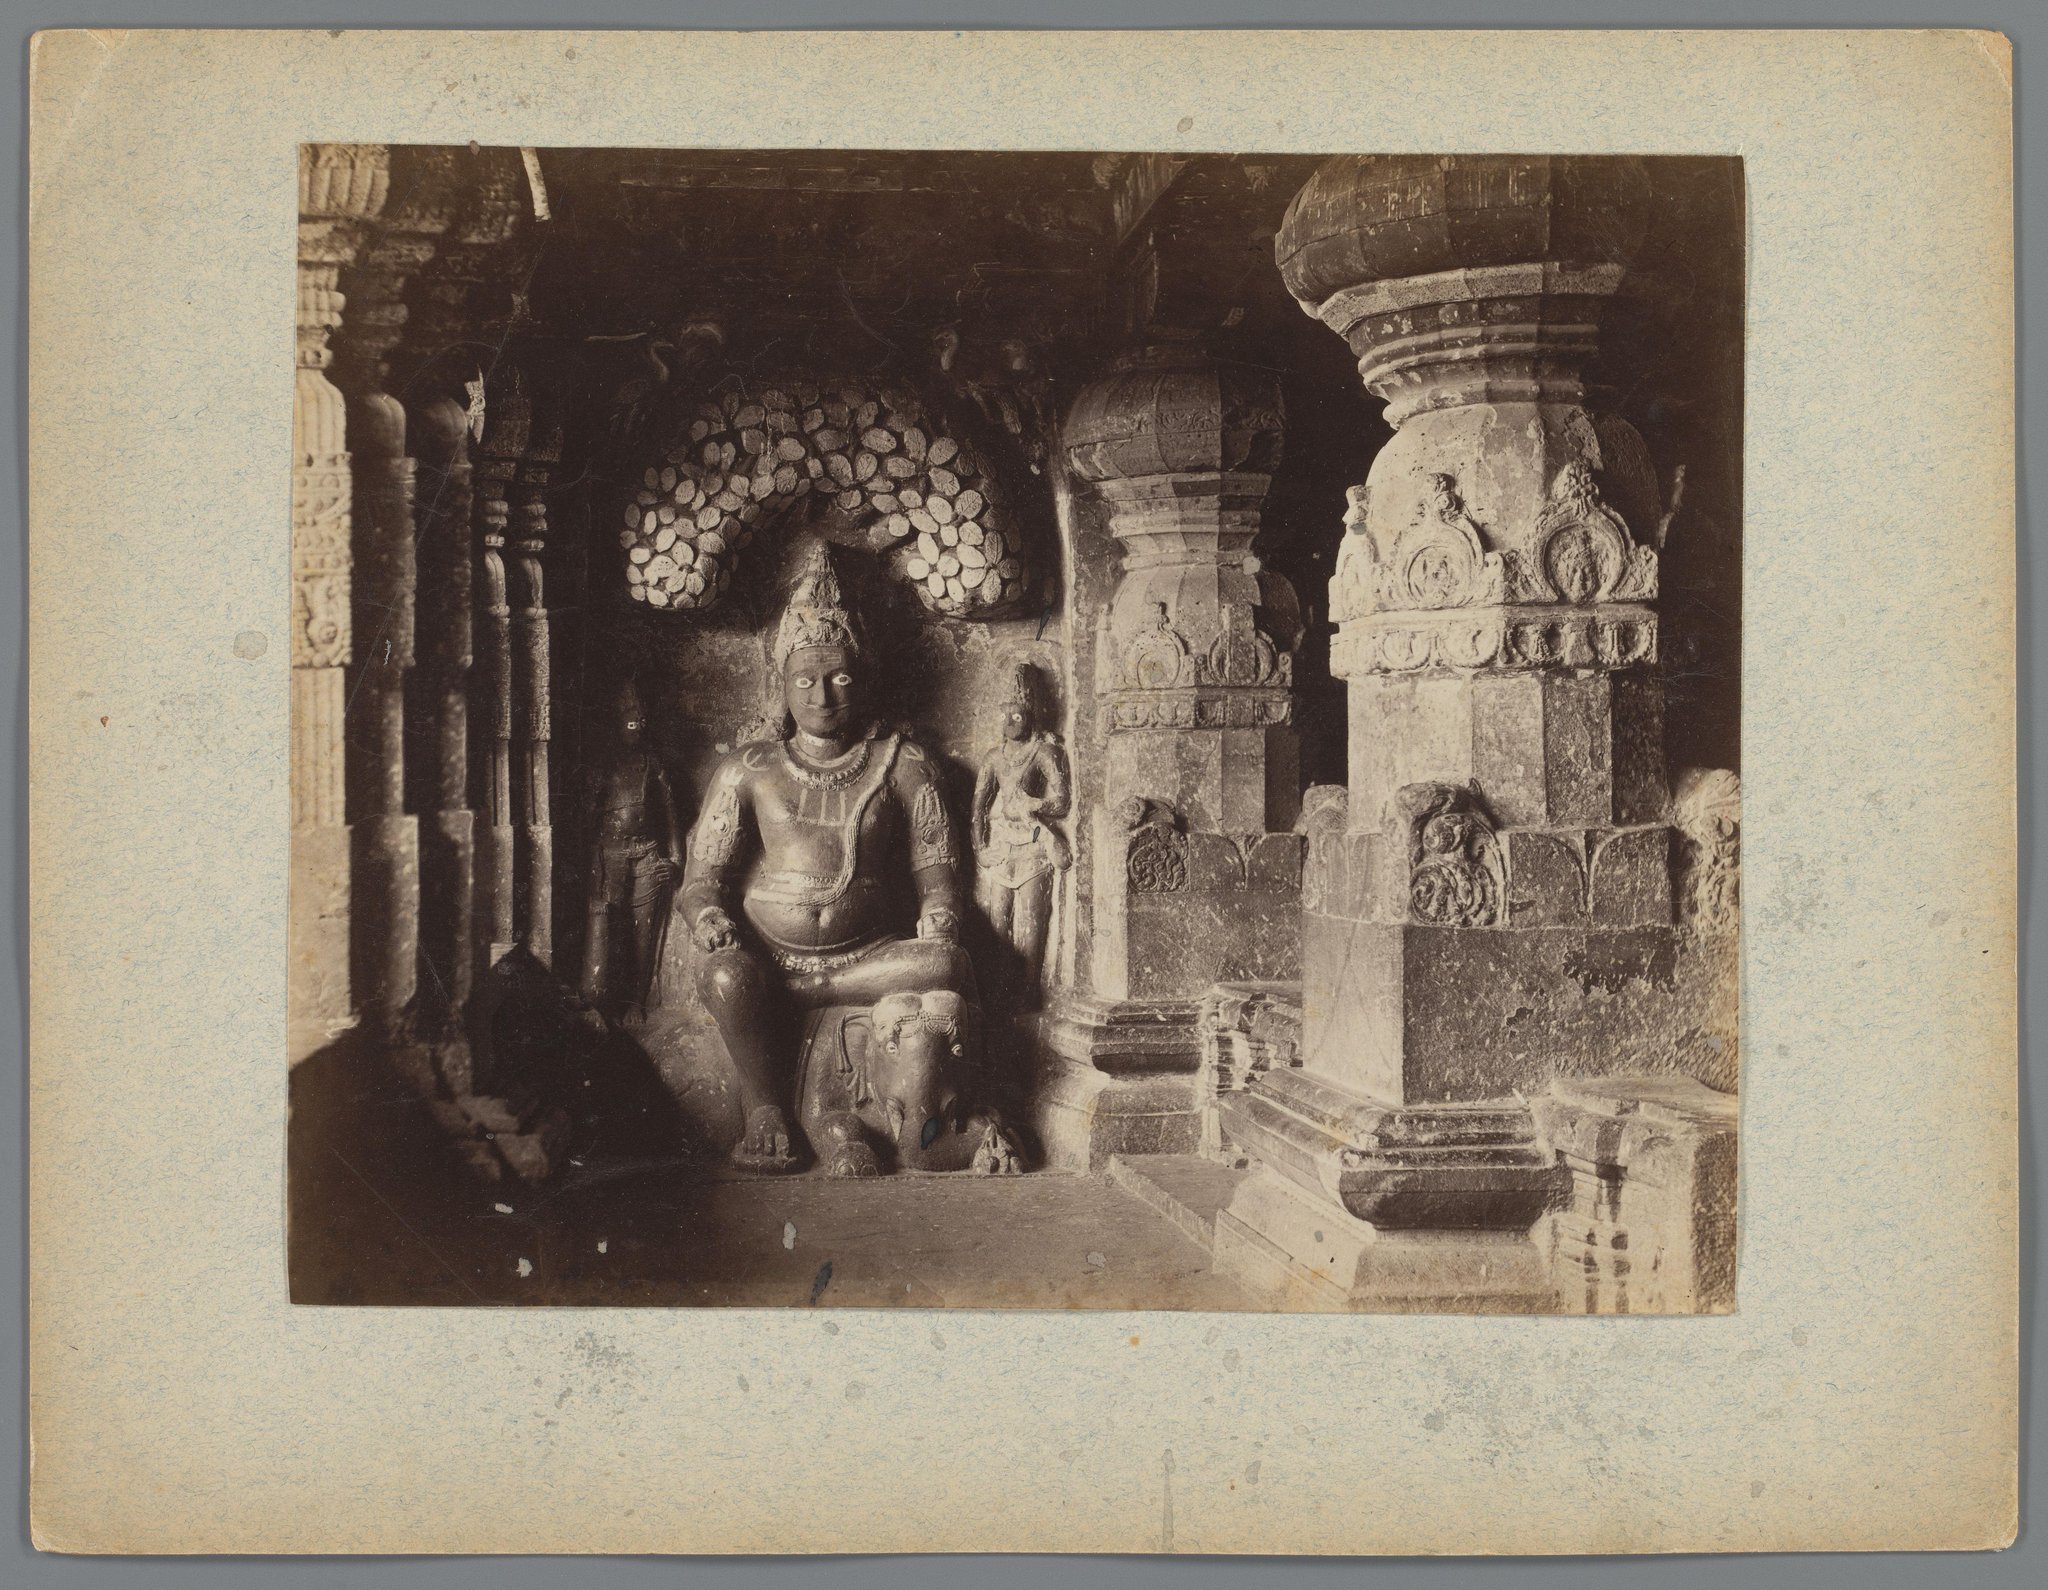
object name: photograph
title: Relief depicting Matanga Yaksha sitting on an elephant, entrance to cave No 32, Indra Sabha temple, Ellora Caves, Maharashtra, India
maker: Anonymous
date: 1870-1890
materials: cardboard, photographic support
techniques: albumen print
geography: ellora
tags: places and objects of worship ~ hinduism, buddhism, jainism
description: Op de achterzijde is een tekening gemaakt van een binnenruimte.